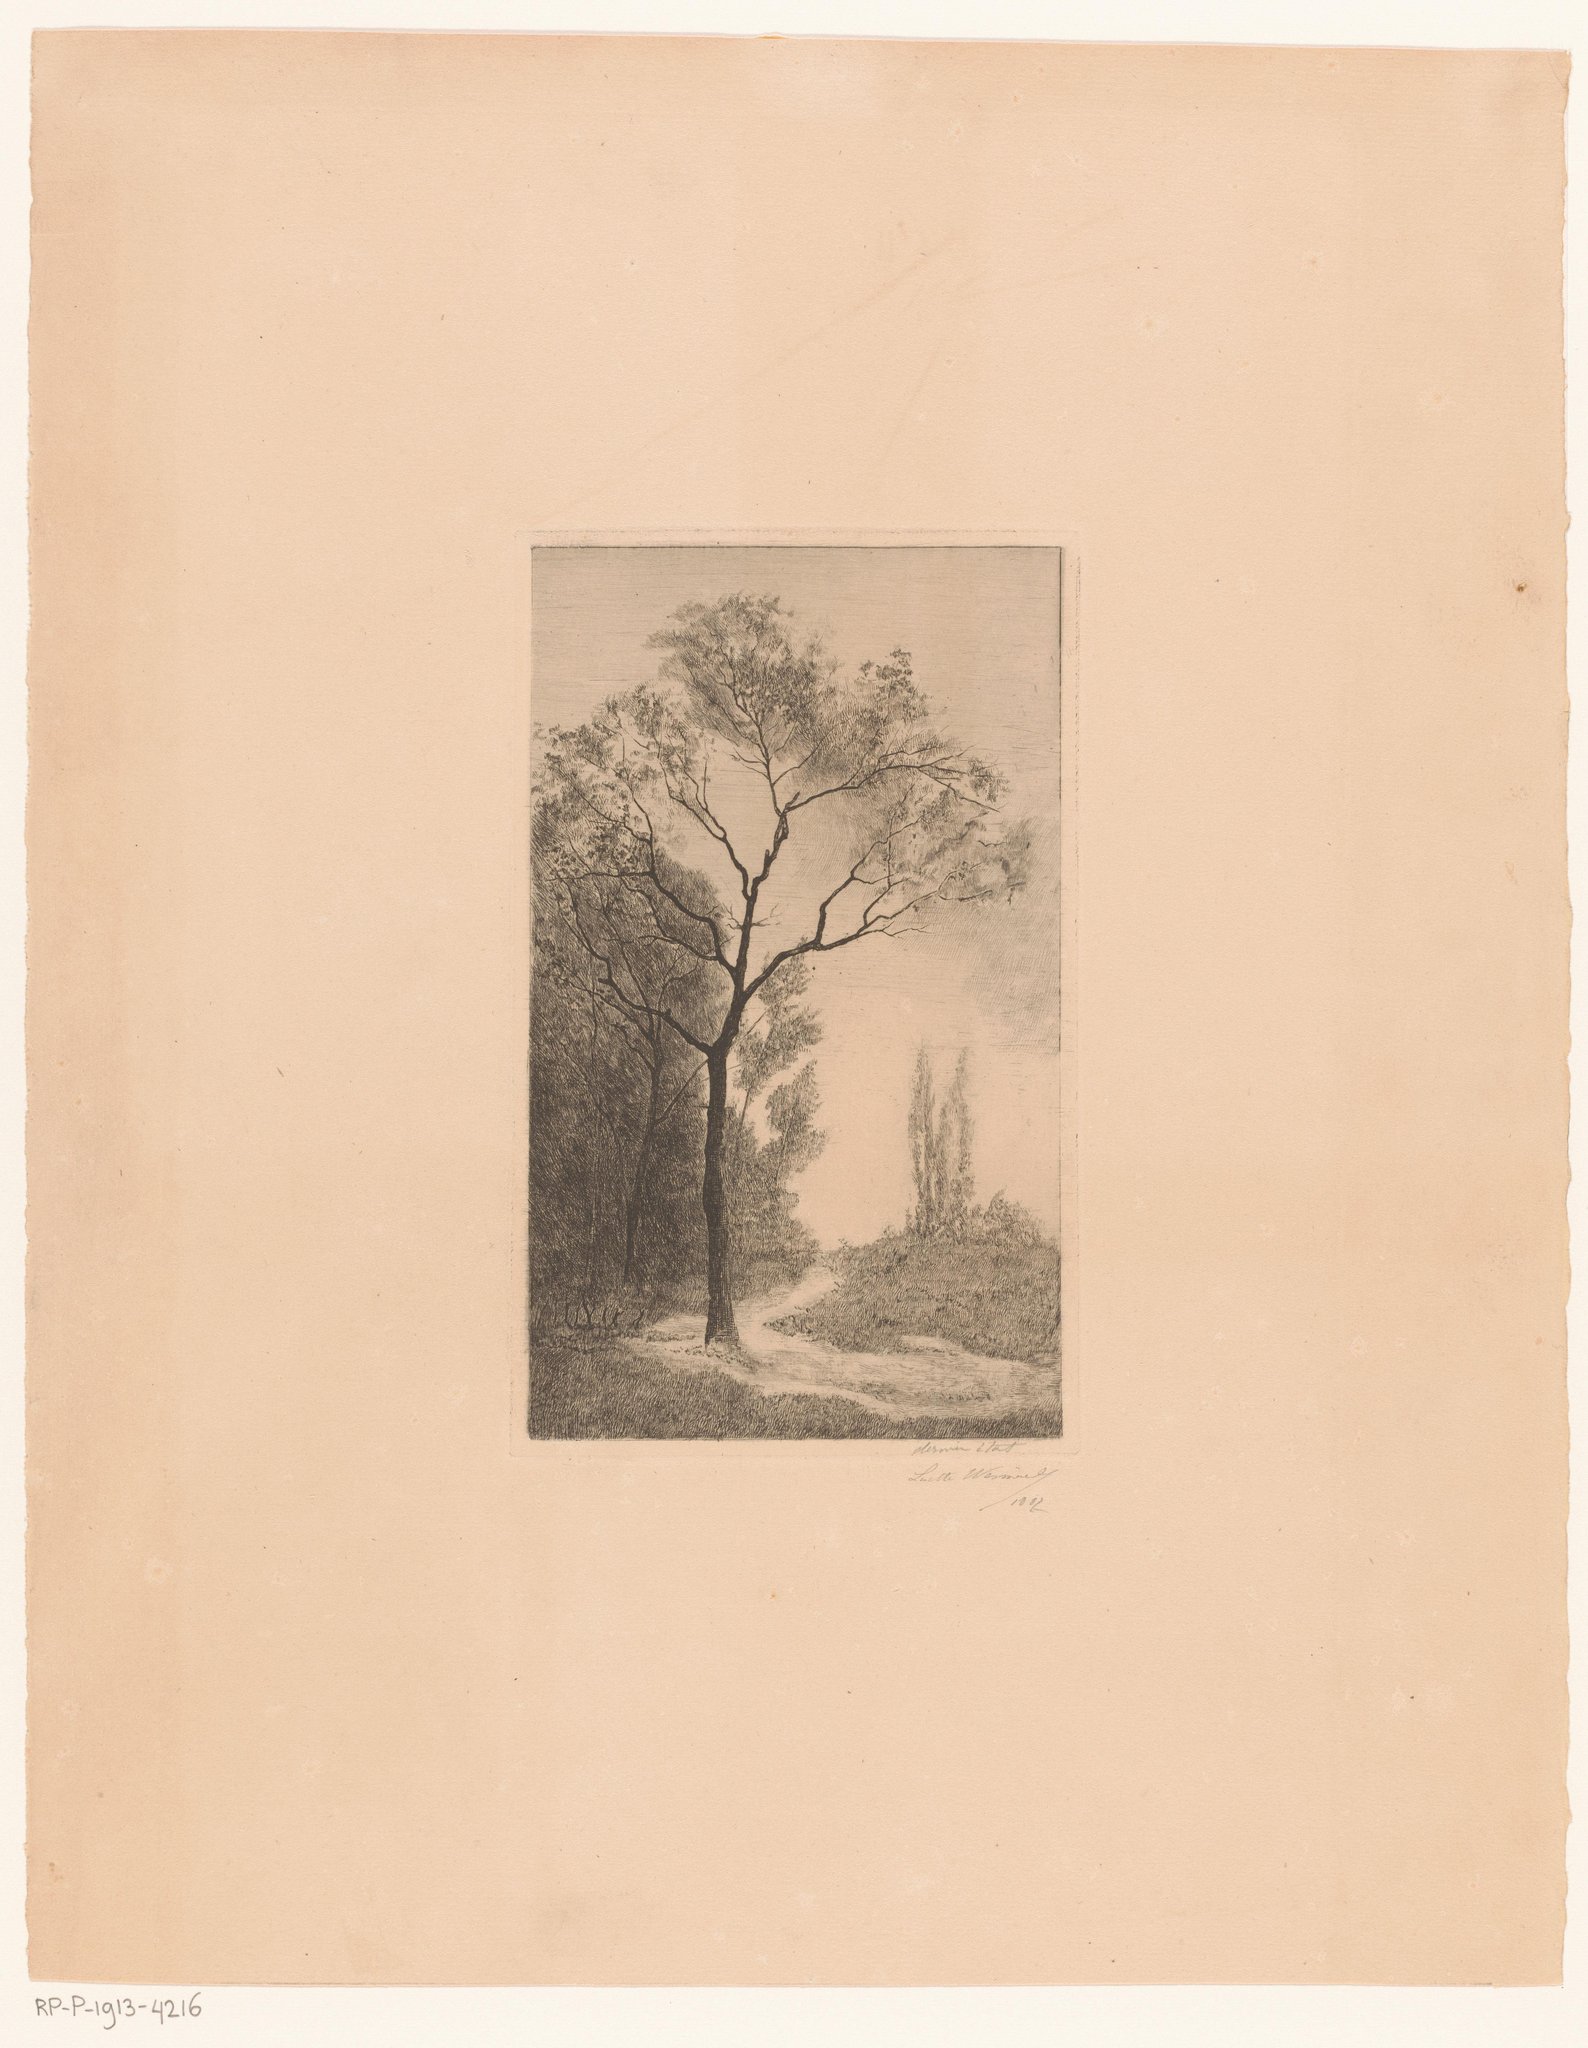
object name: print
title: Landschap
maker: lisette wesmael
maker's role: print maker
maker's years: 1861-1953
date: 1887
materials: paper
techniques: etching, intaglio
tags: landscapes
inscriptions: collector's mark: Lugt 2228, annotation: ‘7 Paysage d'après Huberti’